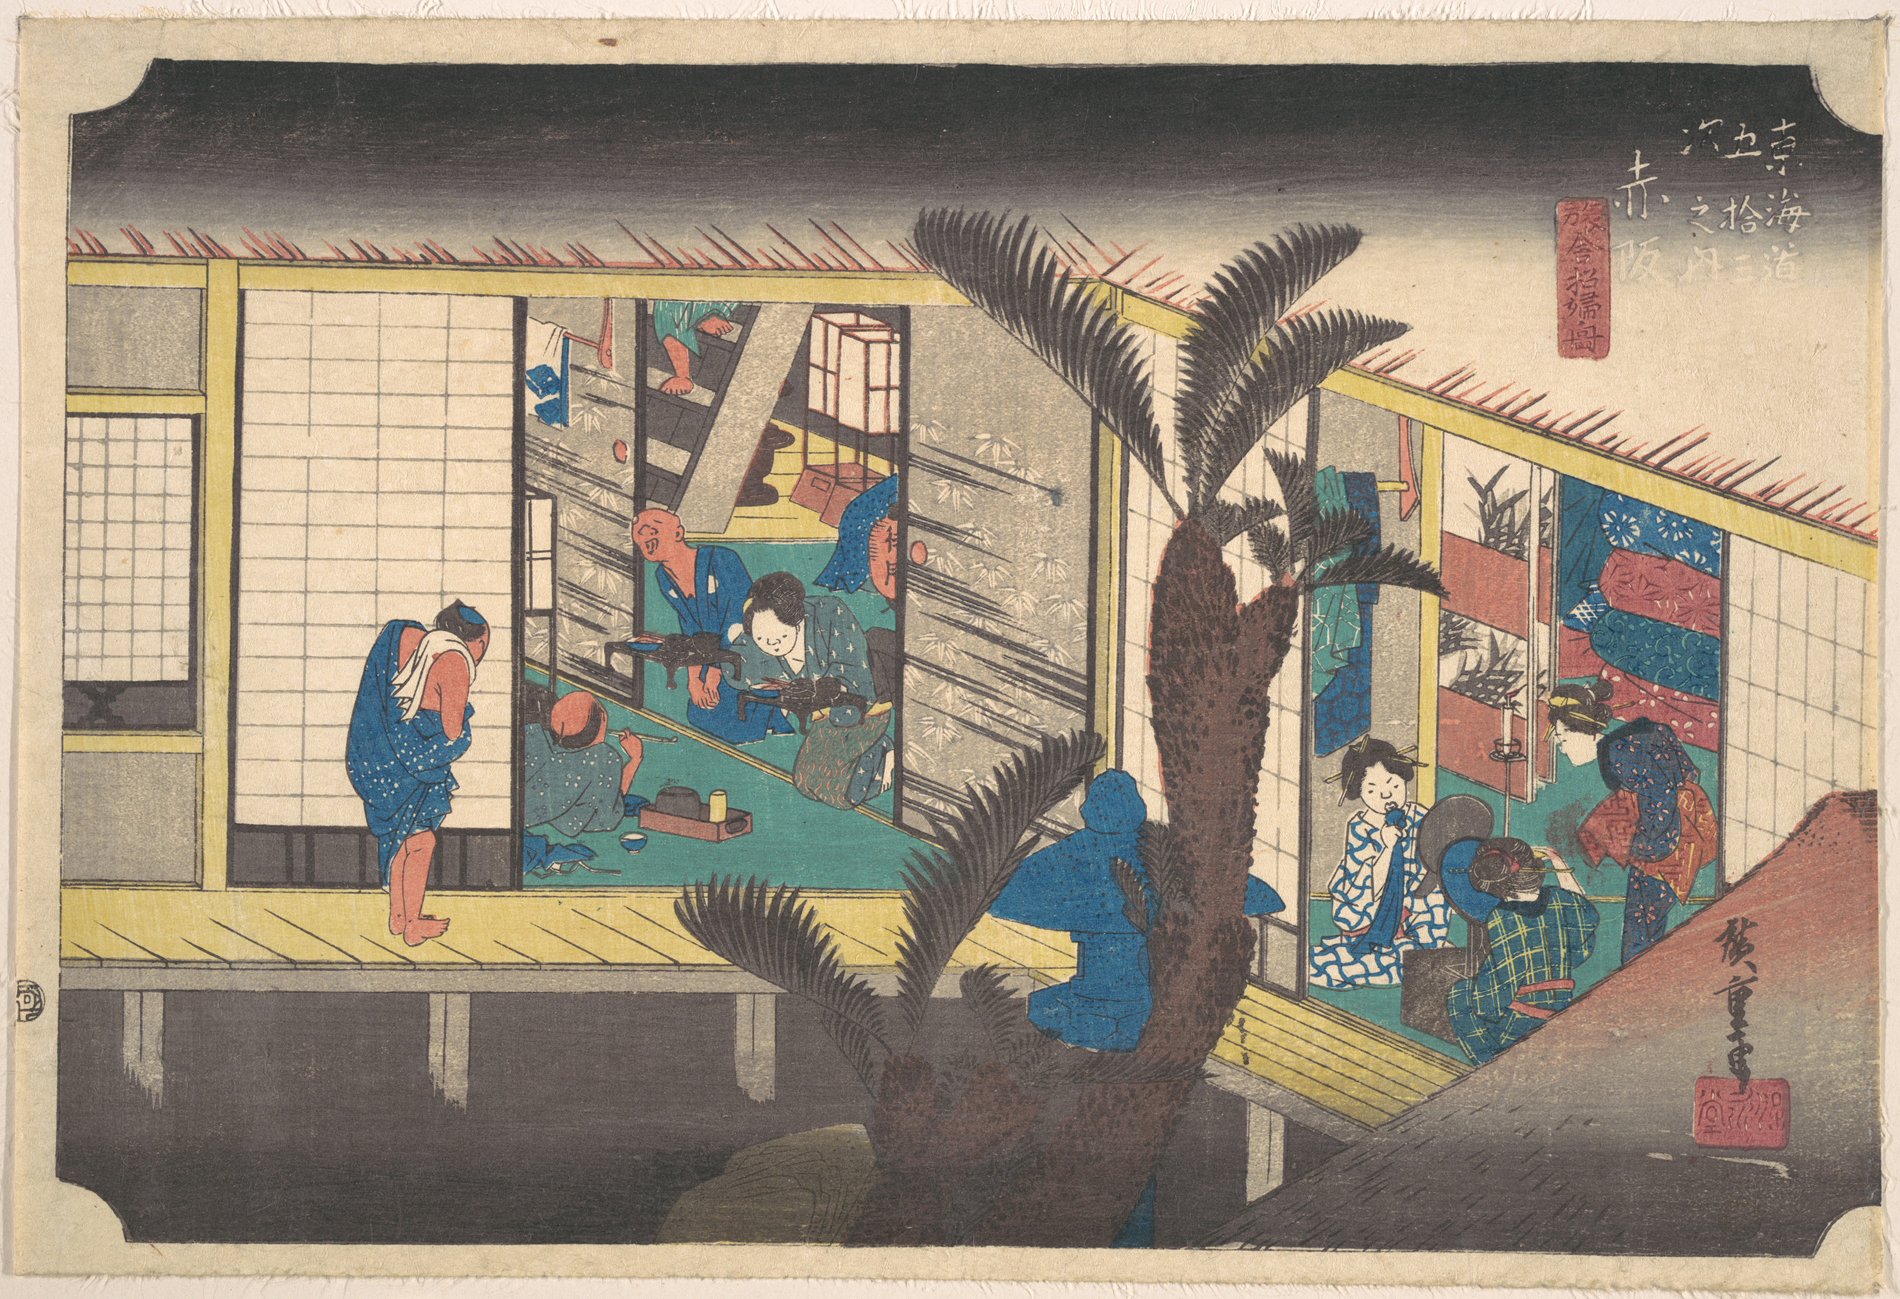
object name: print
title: Akasaka, Ryosha Sho-fu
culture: japanese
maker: utagawa hiroshige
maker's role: artist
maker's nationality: japanese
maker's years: 1797-1858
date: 1834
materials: ink, paper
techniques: woodblock print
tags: human figures,trees